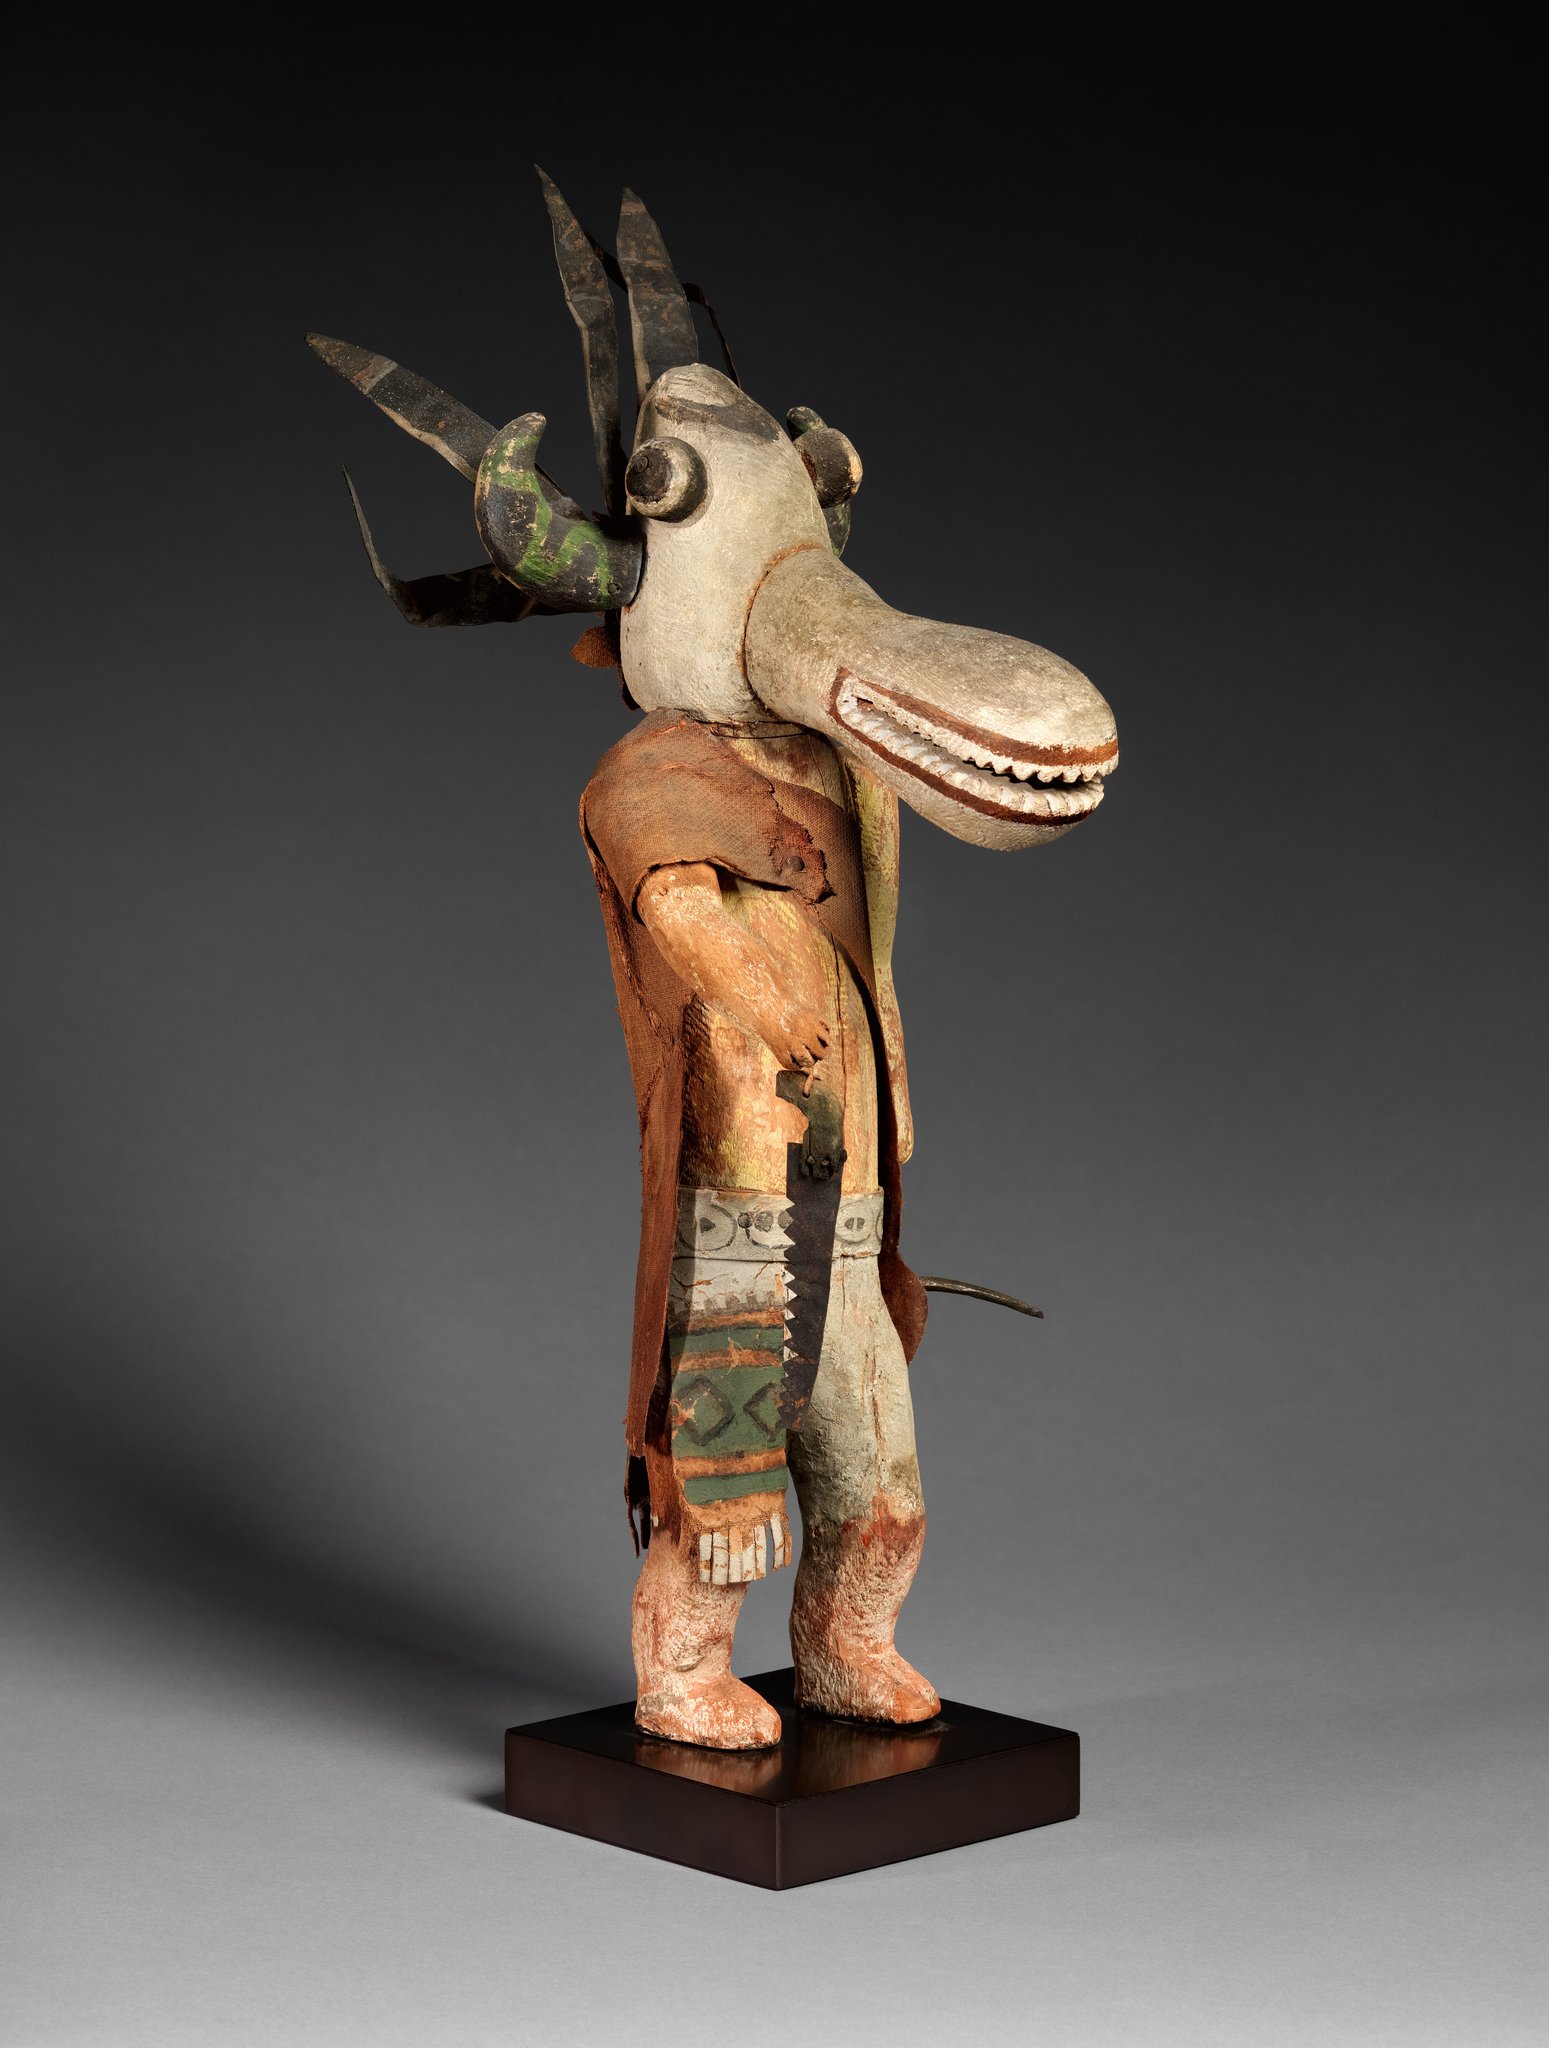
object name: katsina figure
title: White Ogre Tihu (Katsina Figure)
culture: hopi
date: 1900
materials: textile, cotton, leather, metal, pigment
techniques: tanning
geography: united states